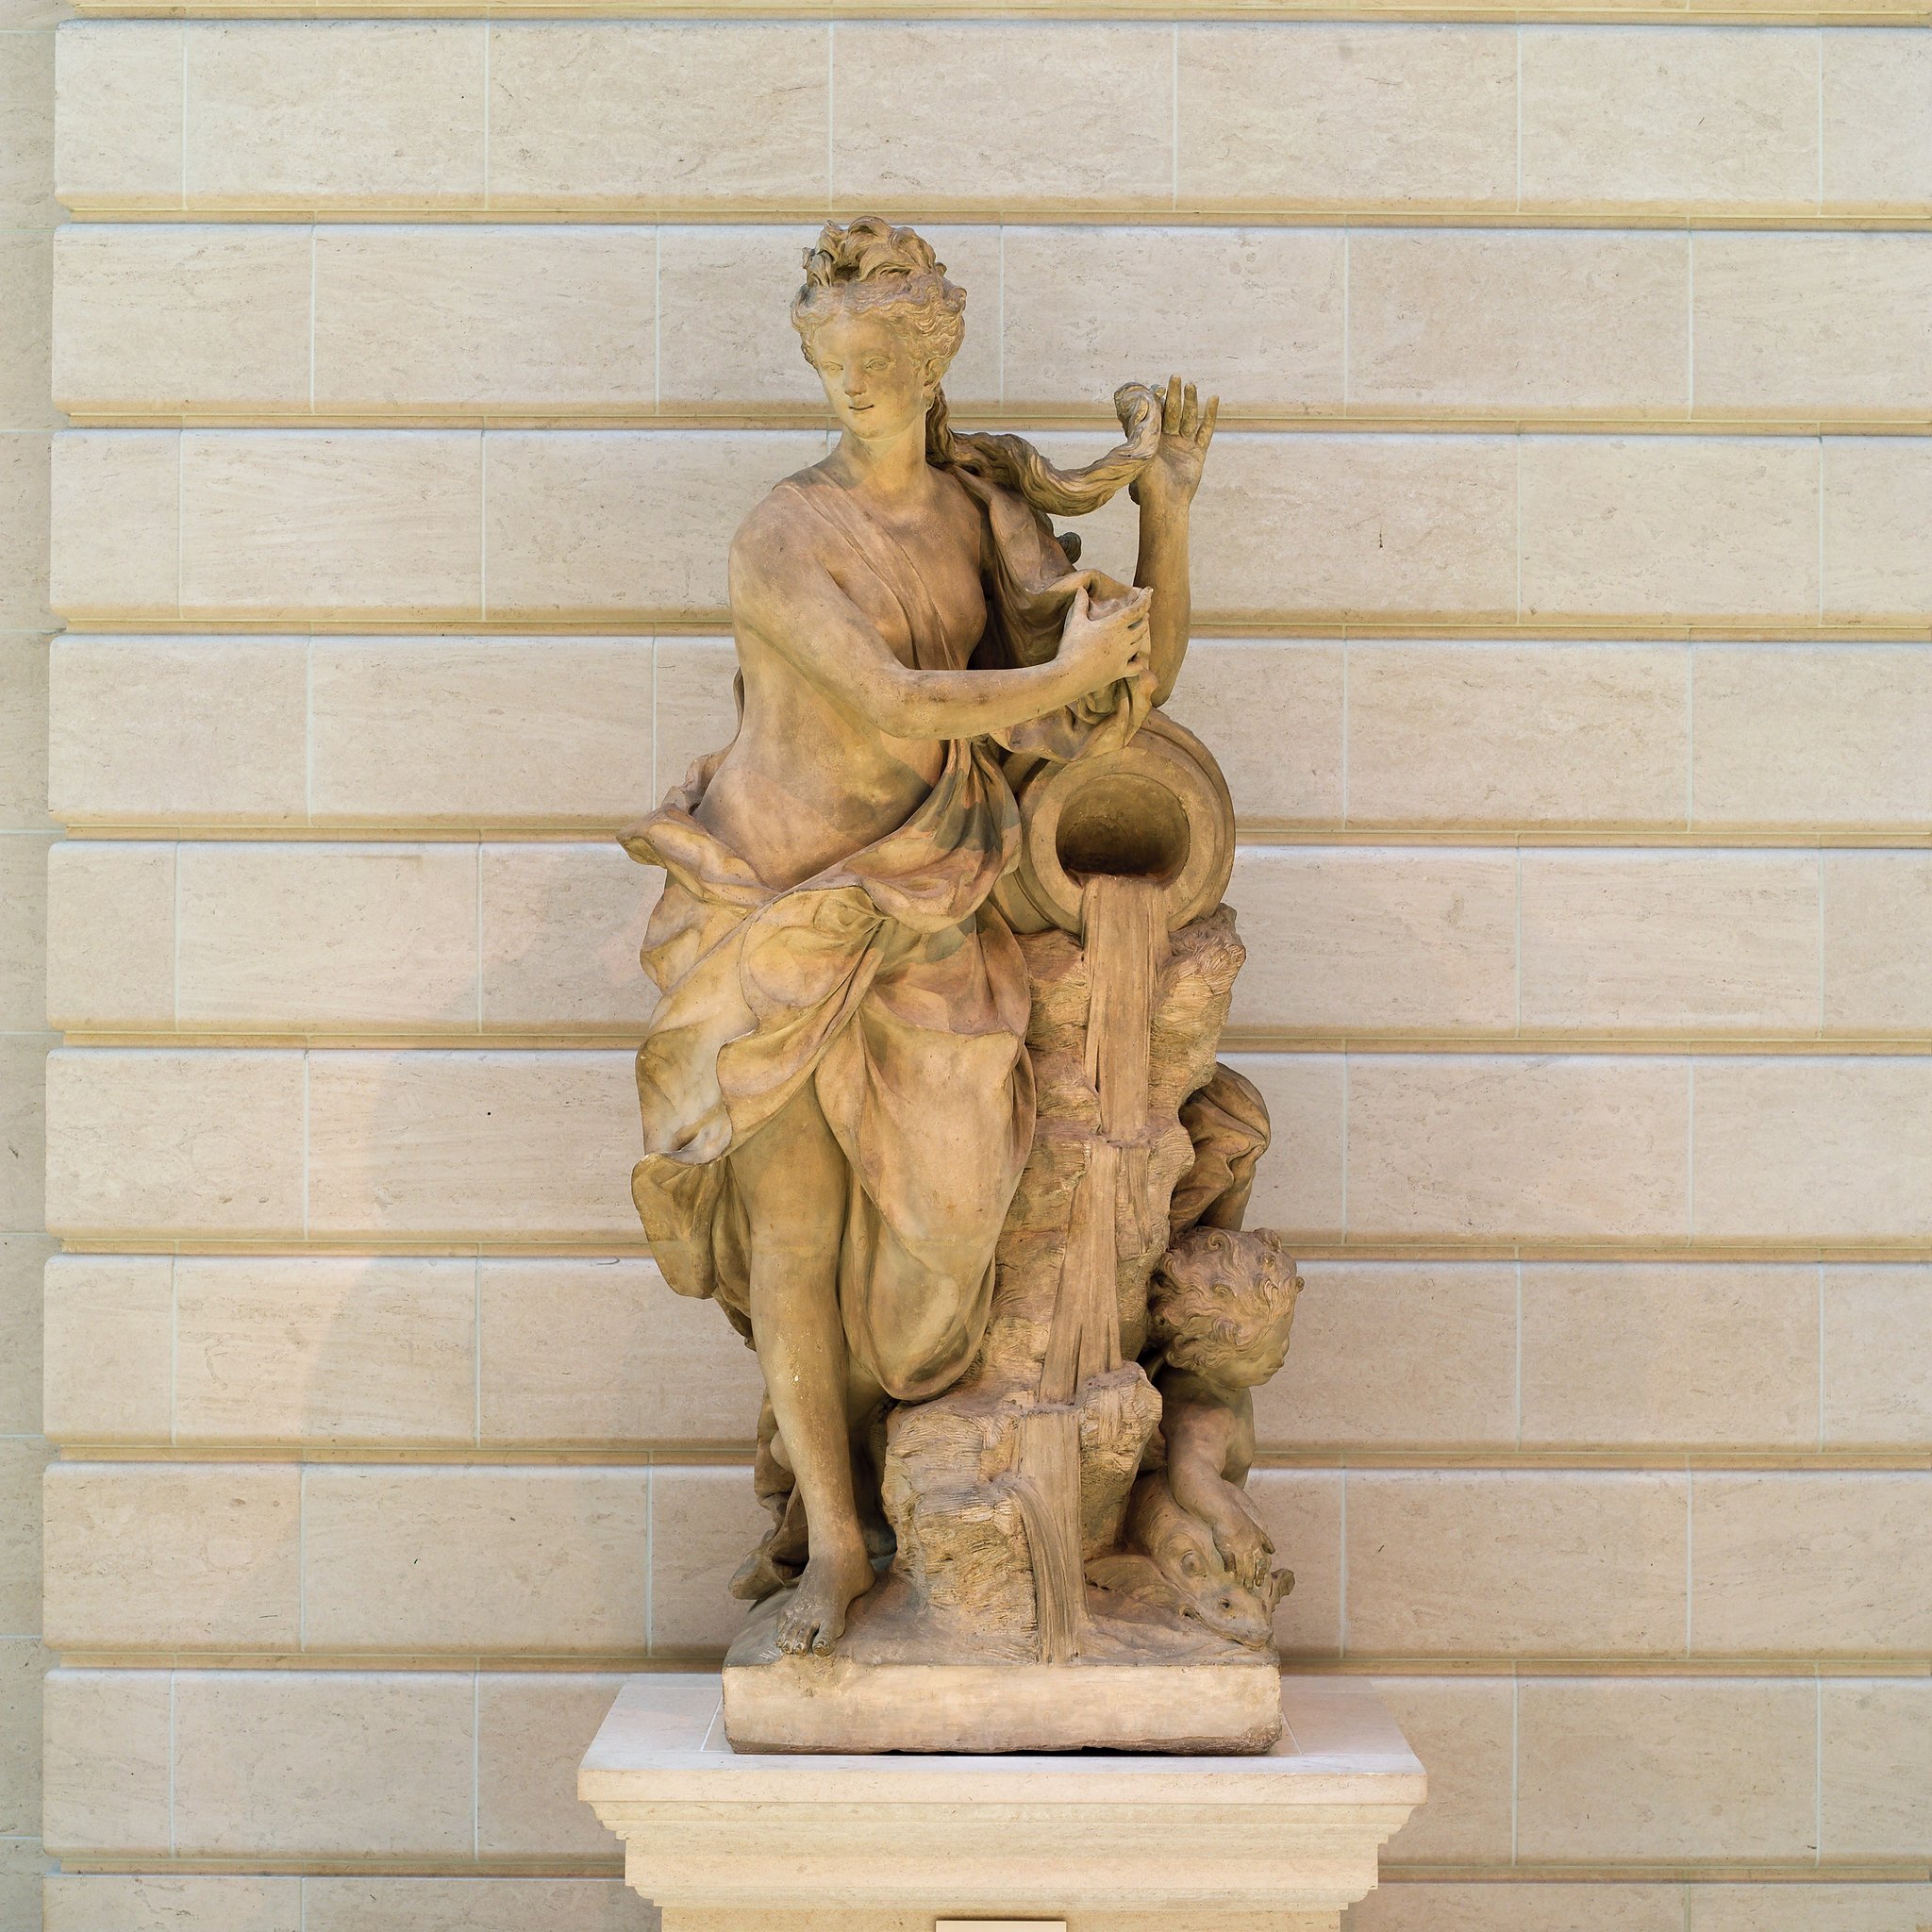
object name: statue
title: Water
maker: jean-pierre defrance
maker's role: artist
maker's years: 1694-1768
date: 1750-1760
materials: limestone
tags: women,putti